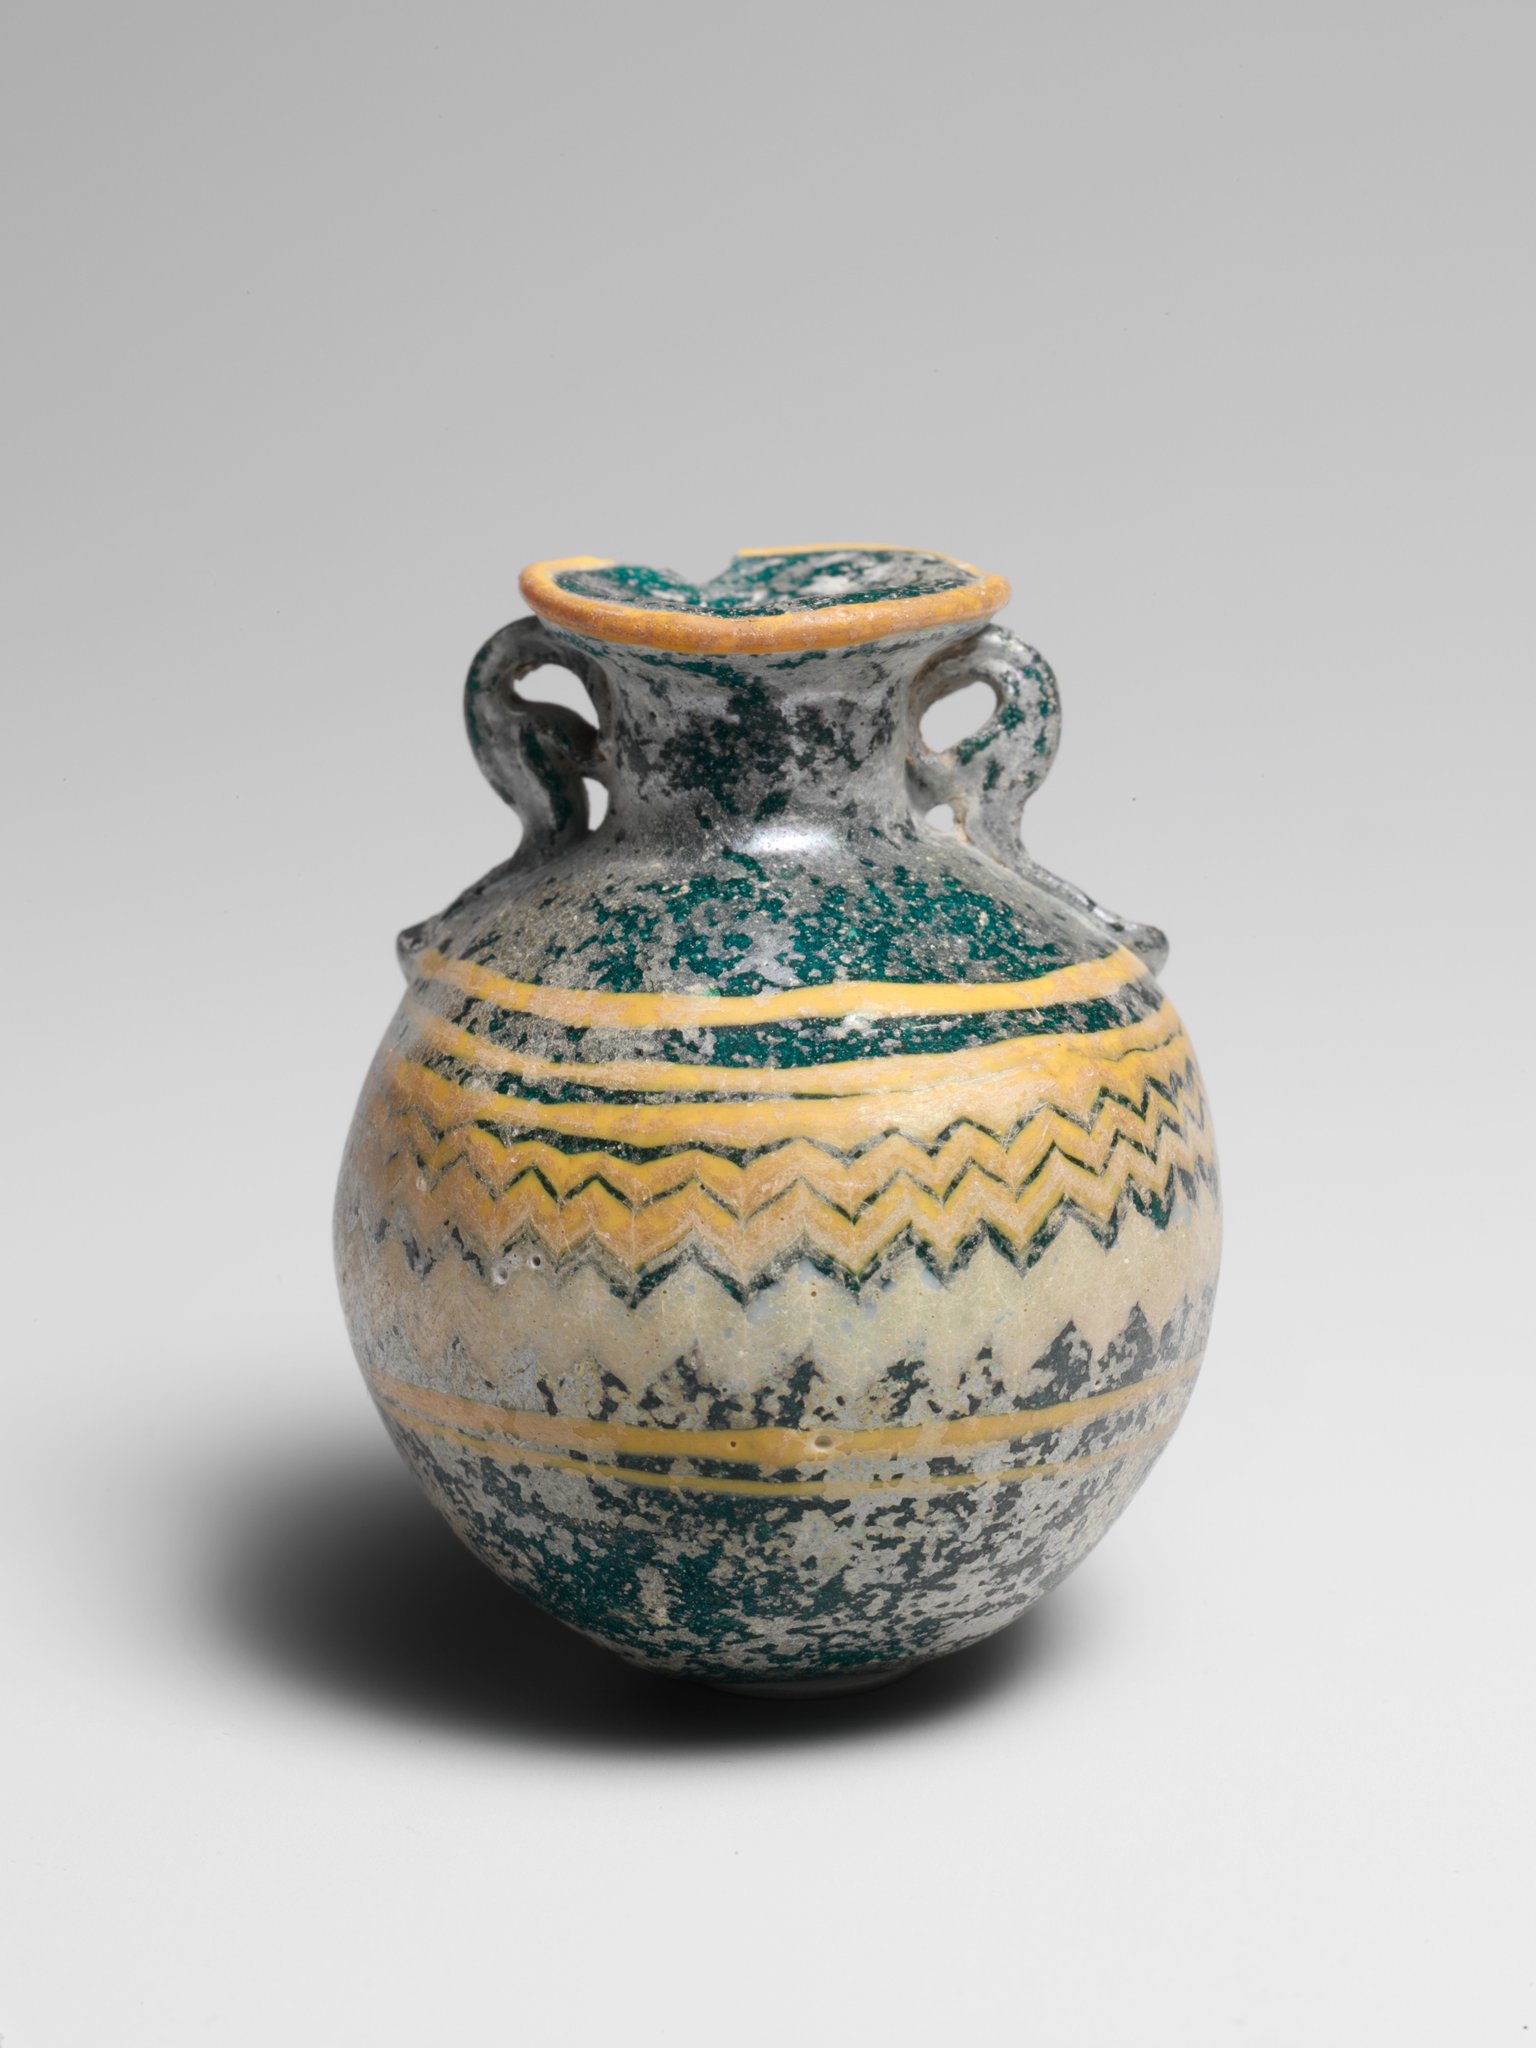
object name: aryballos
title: Glass aryballos (perfume bottle)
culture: greek, eastern mediterranean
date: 534-401 BCE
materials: glass